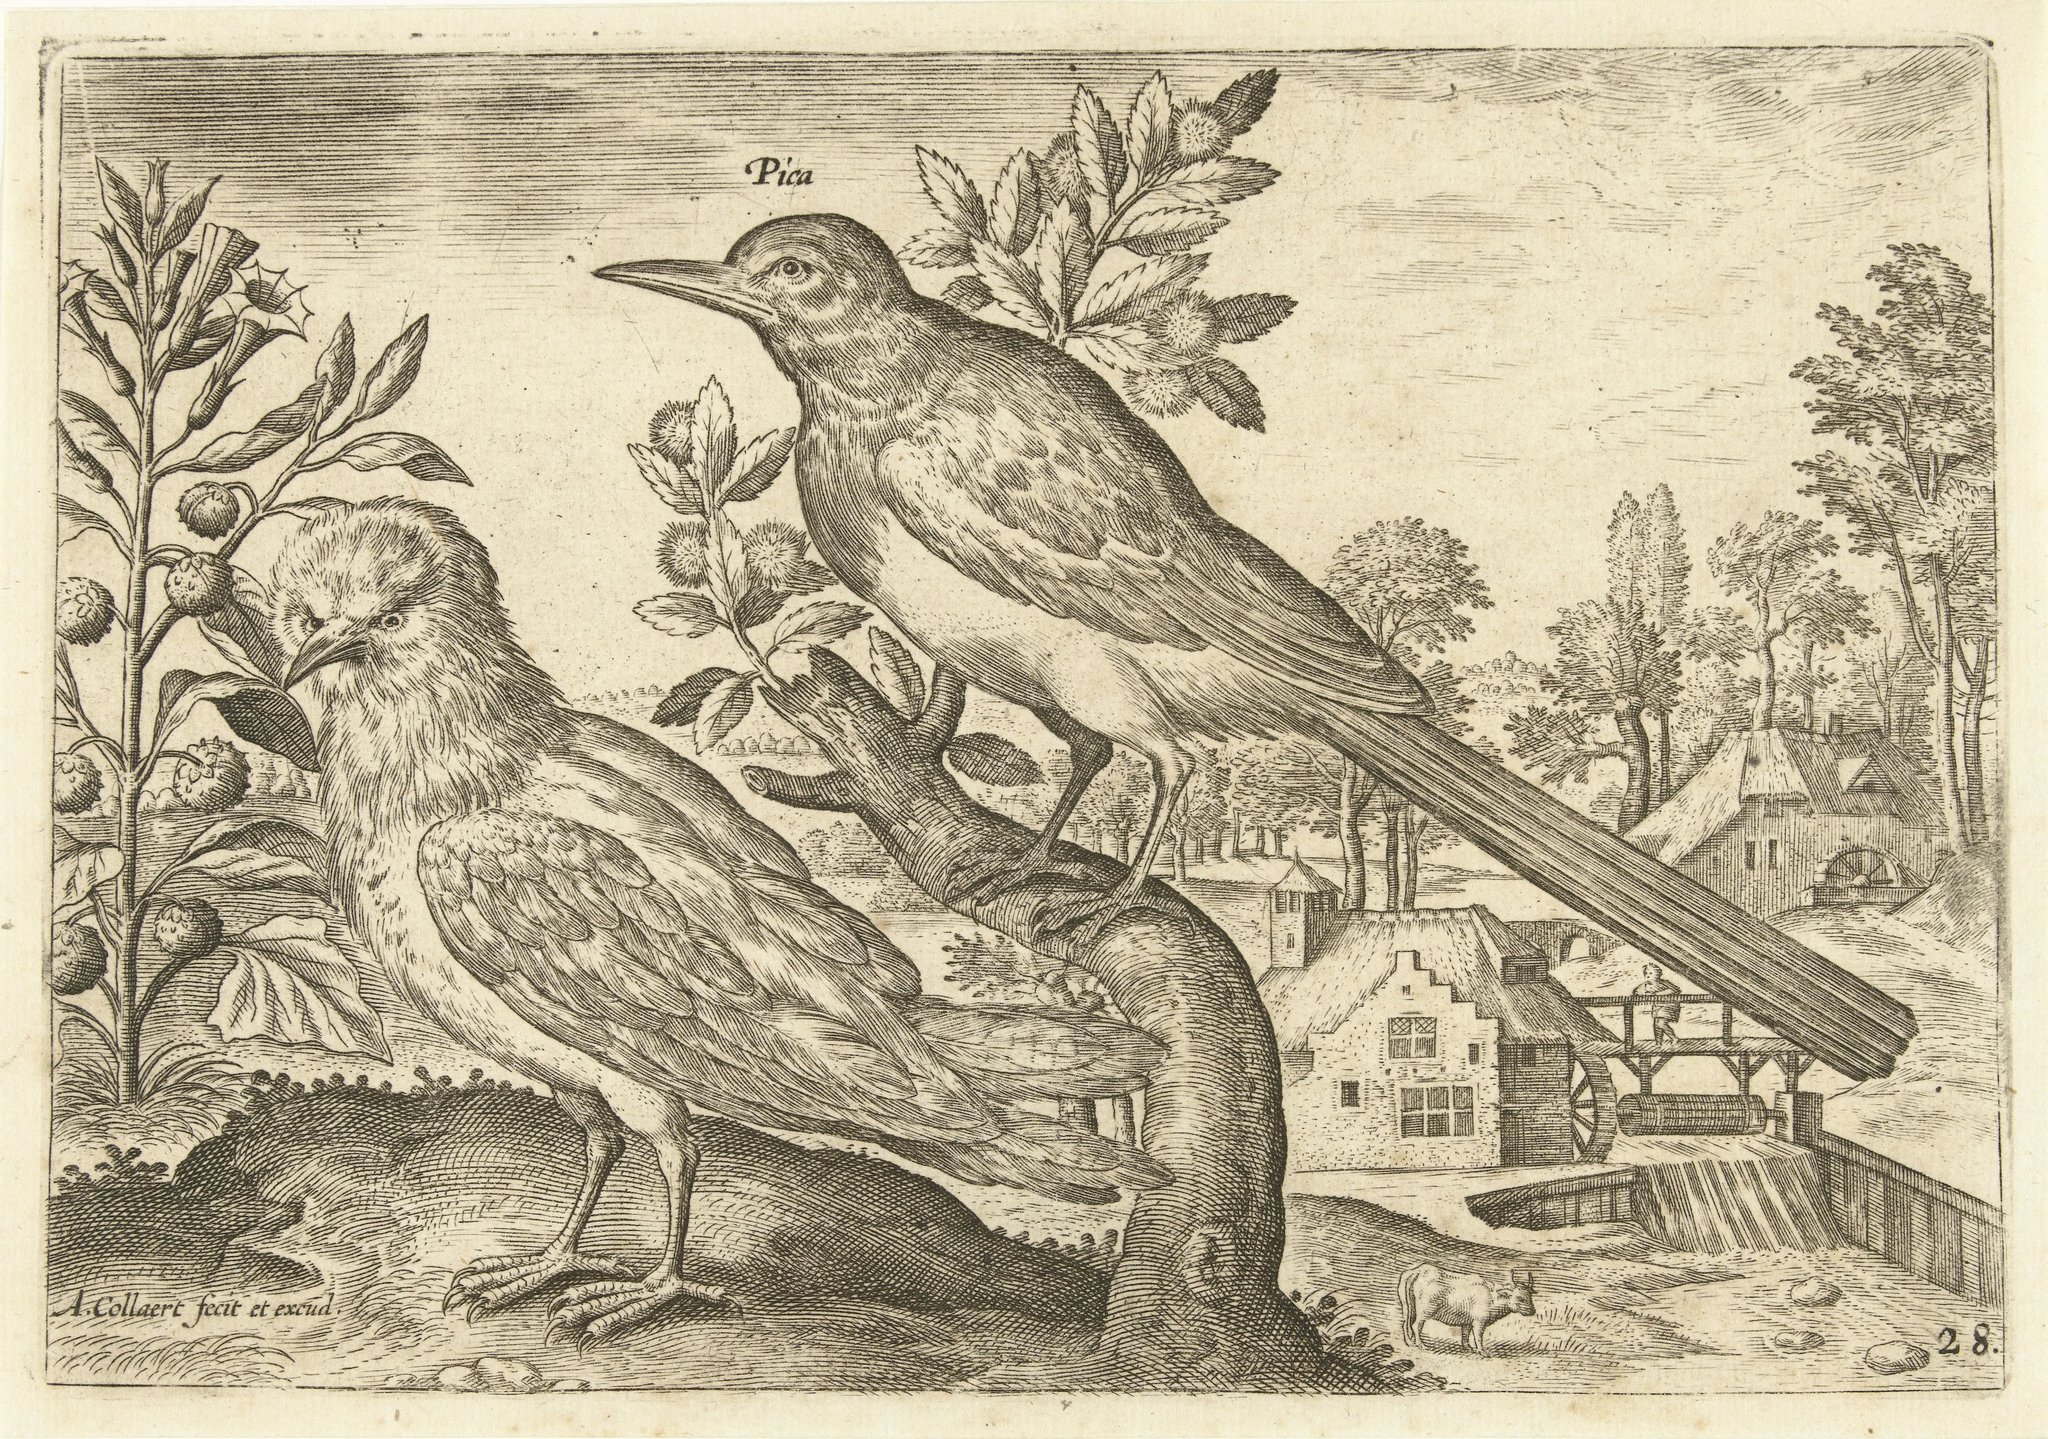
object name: print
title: Avivm Vivae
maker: adriaen collaert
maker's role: draughtsman, print maker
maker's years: 1560-1618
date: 1598-1602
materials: paper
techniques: engraving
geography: antwerp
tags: song-birds, watermill in landscape (+ city(-scape) with figures, staffage), song-birds: magpie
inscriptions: collector's mark: Lugt 2228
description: Een ekster en een andere vogel in een landschap met een watermolen. De prent maakt deel uit van een serie met vogels als onderwerp.